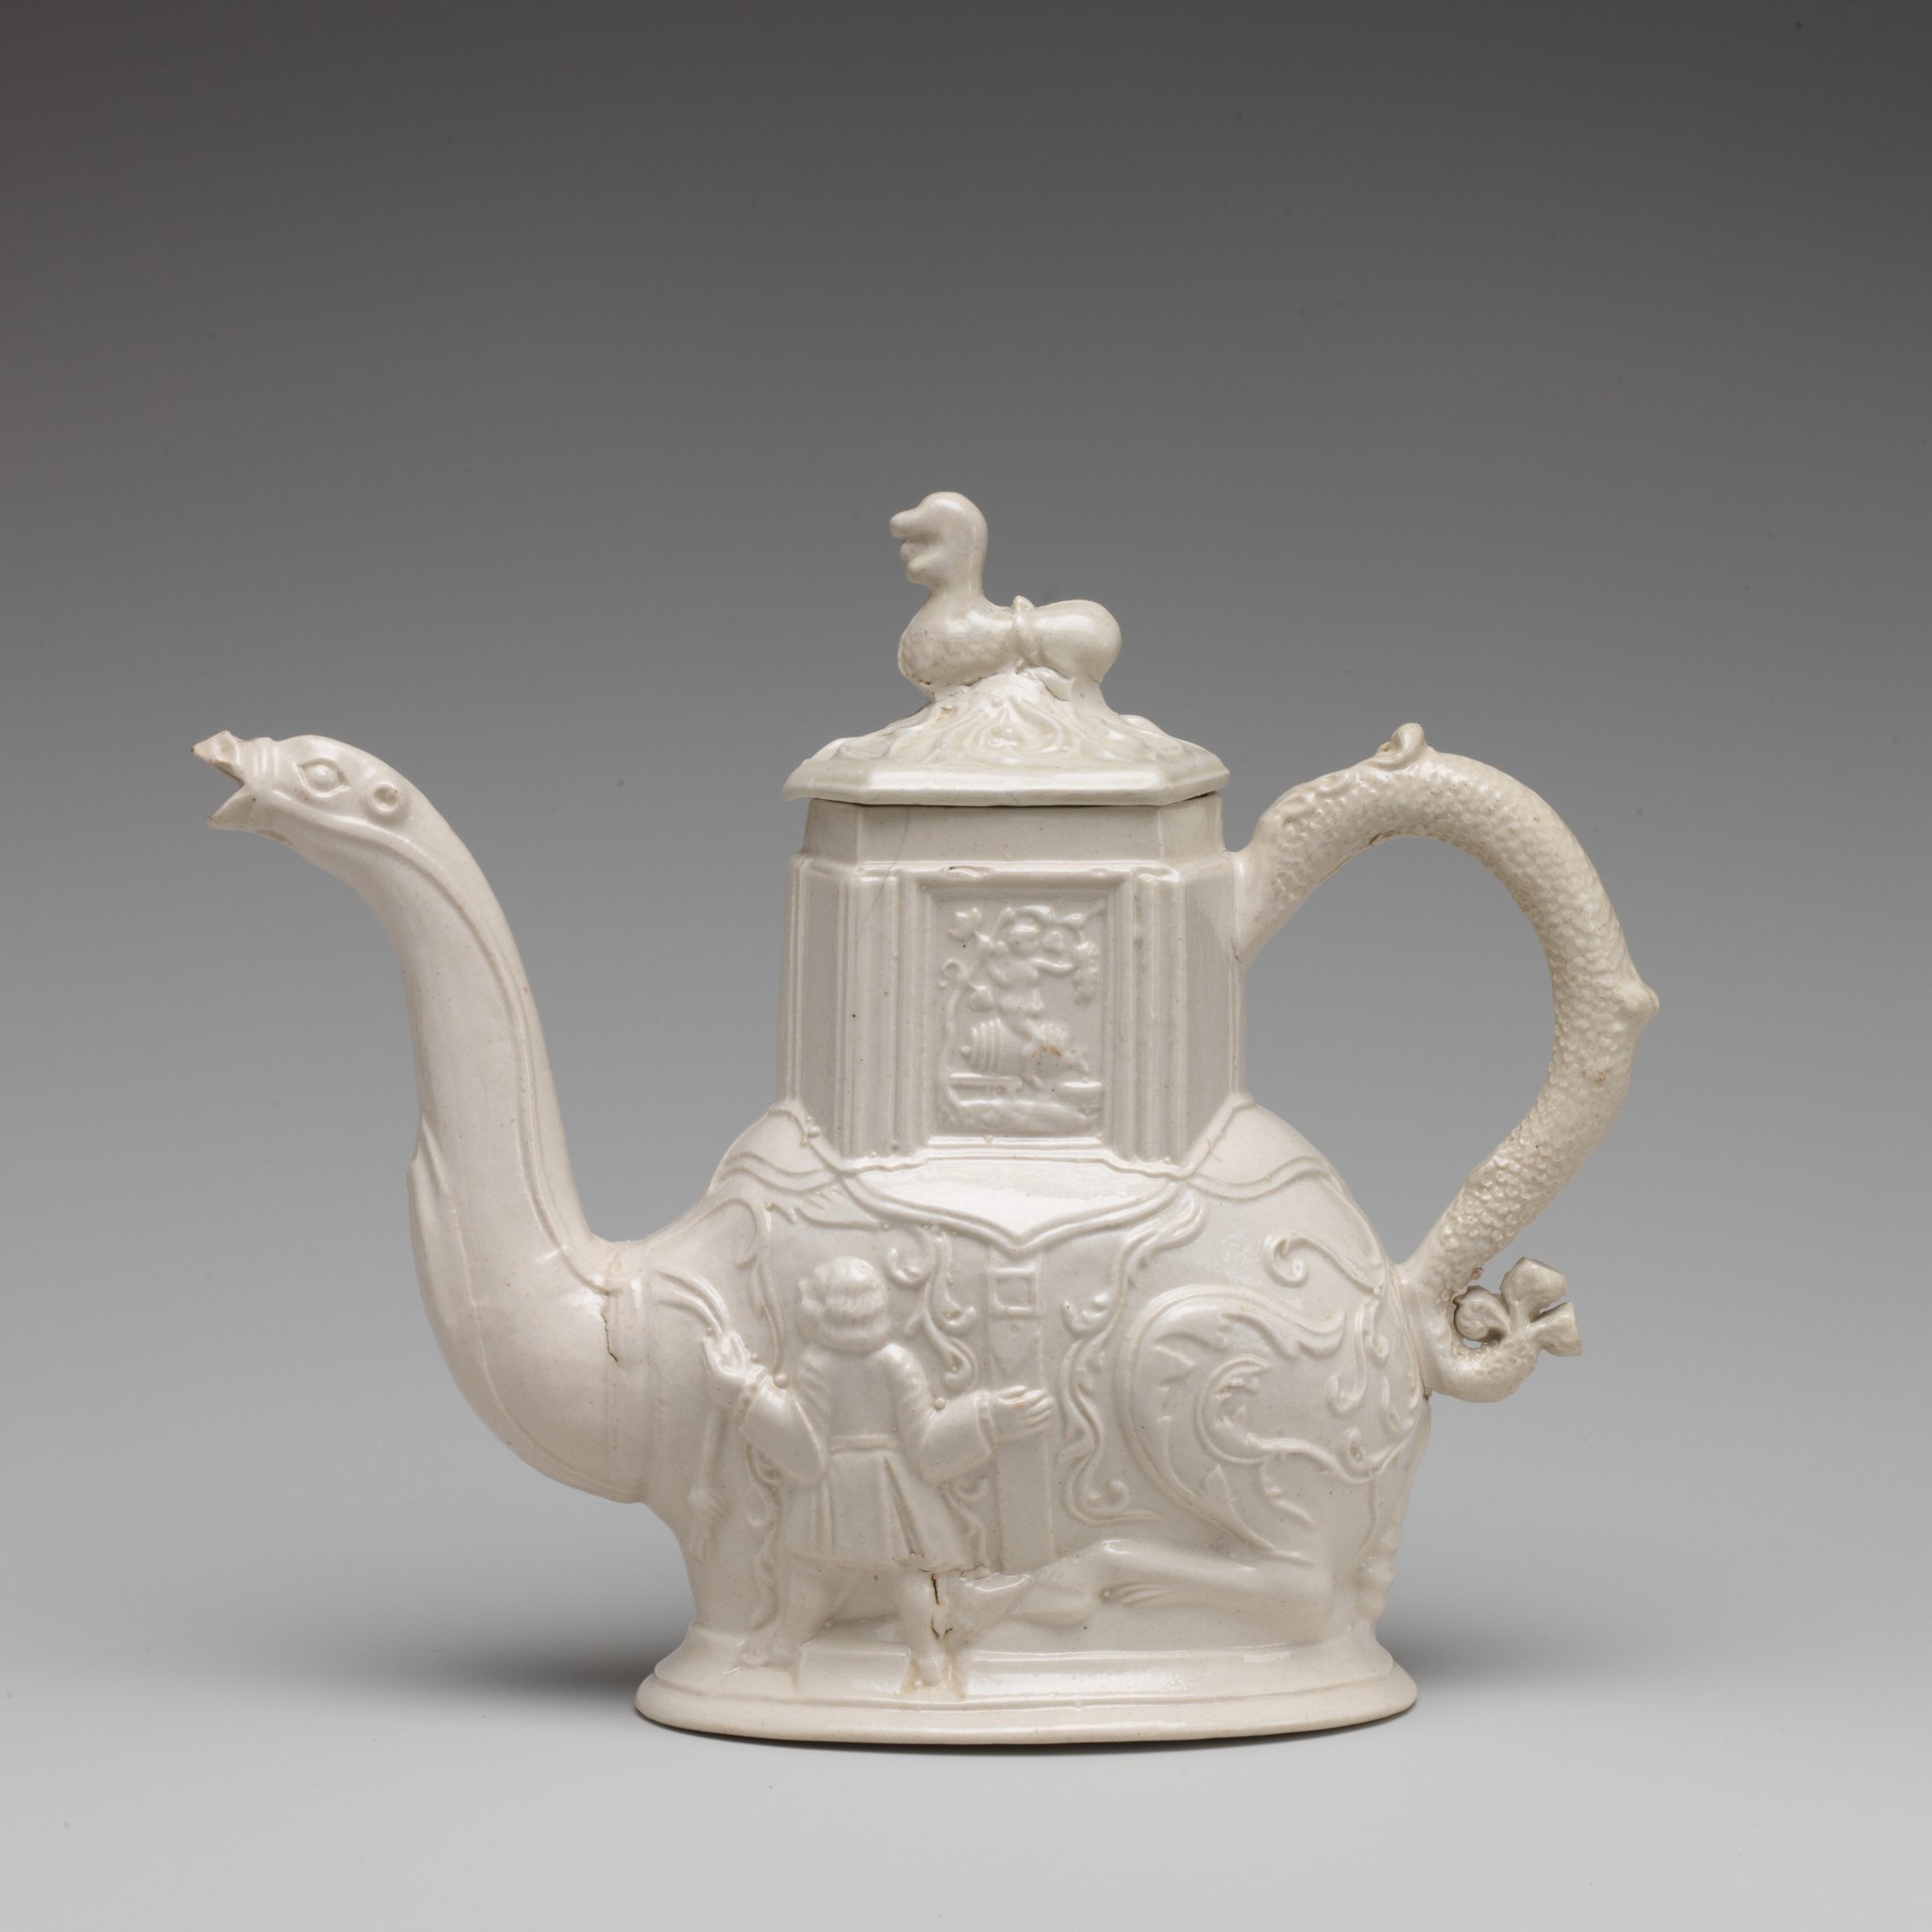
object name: teapot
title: Teapot in the form of a camel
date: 1745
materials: stoneware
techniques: salt glaze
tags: human figures,animals